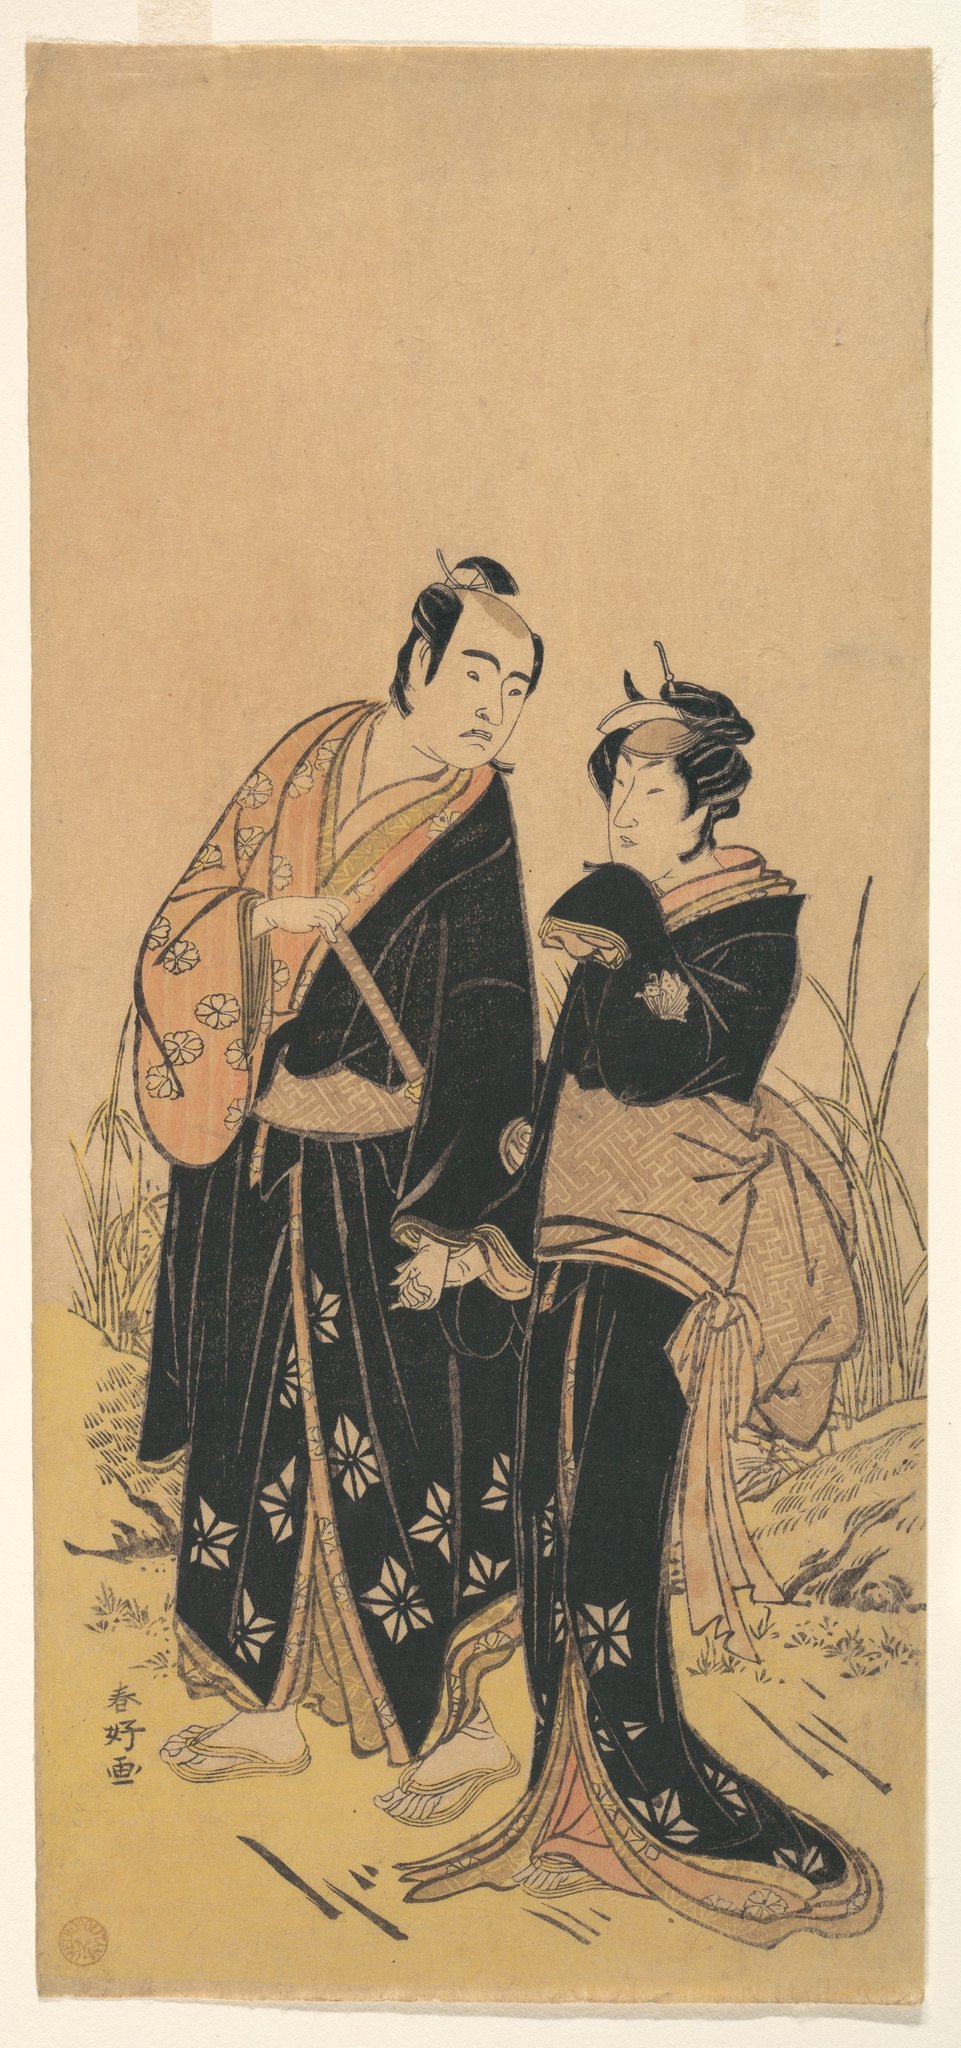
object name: print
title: The Third Segawa Sojuro and the Third Segawa Kikunojo as Lovers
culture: japanese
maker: katsukawa shunkō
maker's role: artist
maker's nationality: japanese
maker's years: 1743-1812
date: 1779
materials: ink, paper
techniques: woodblock print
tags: men,lovers,women,actors